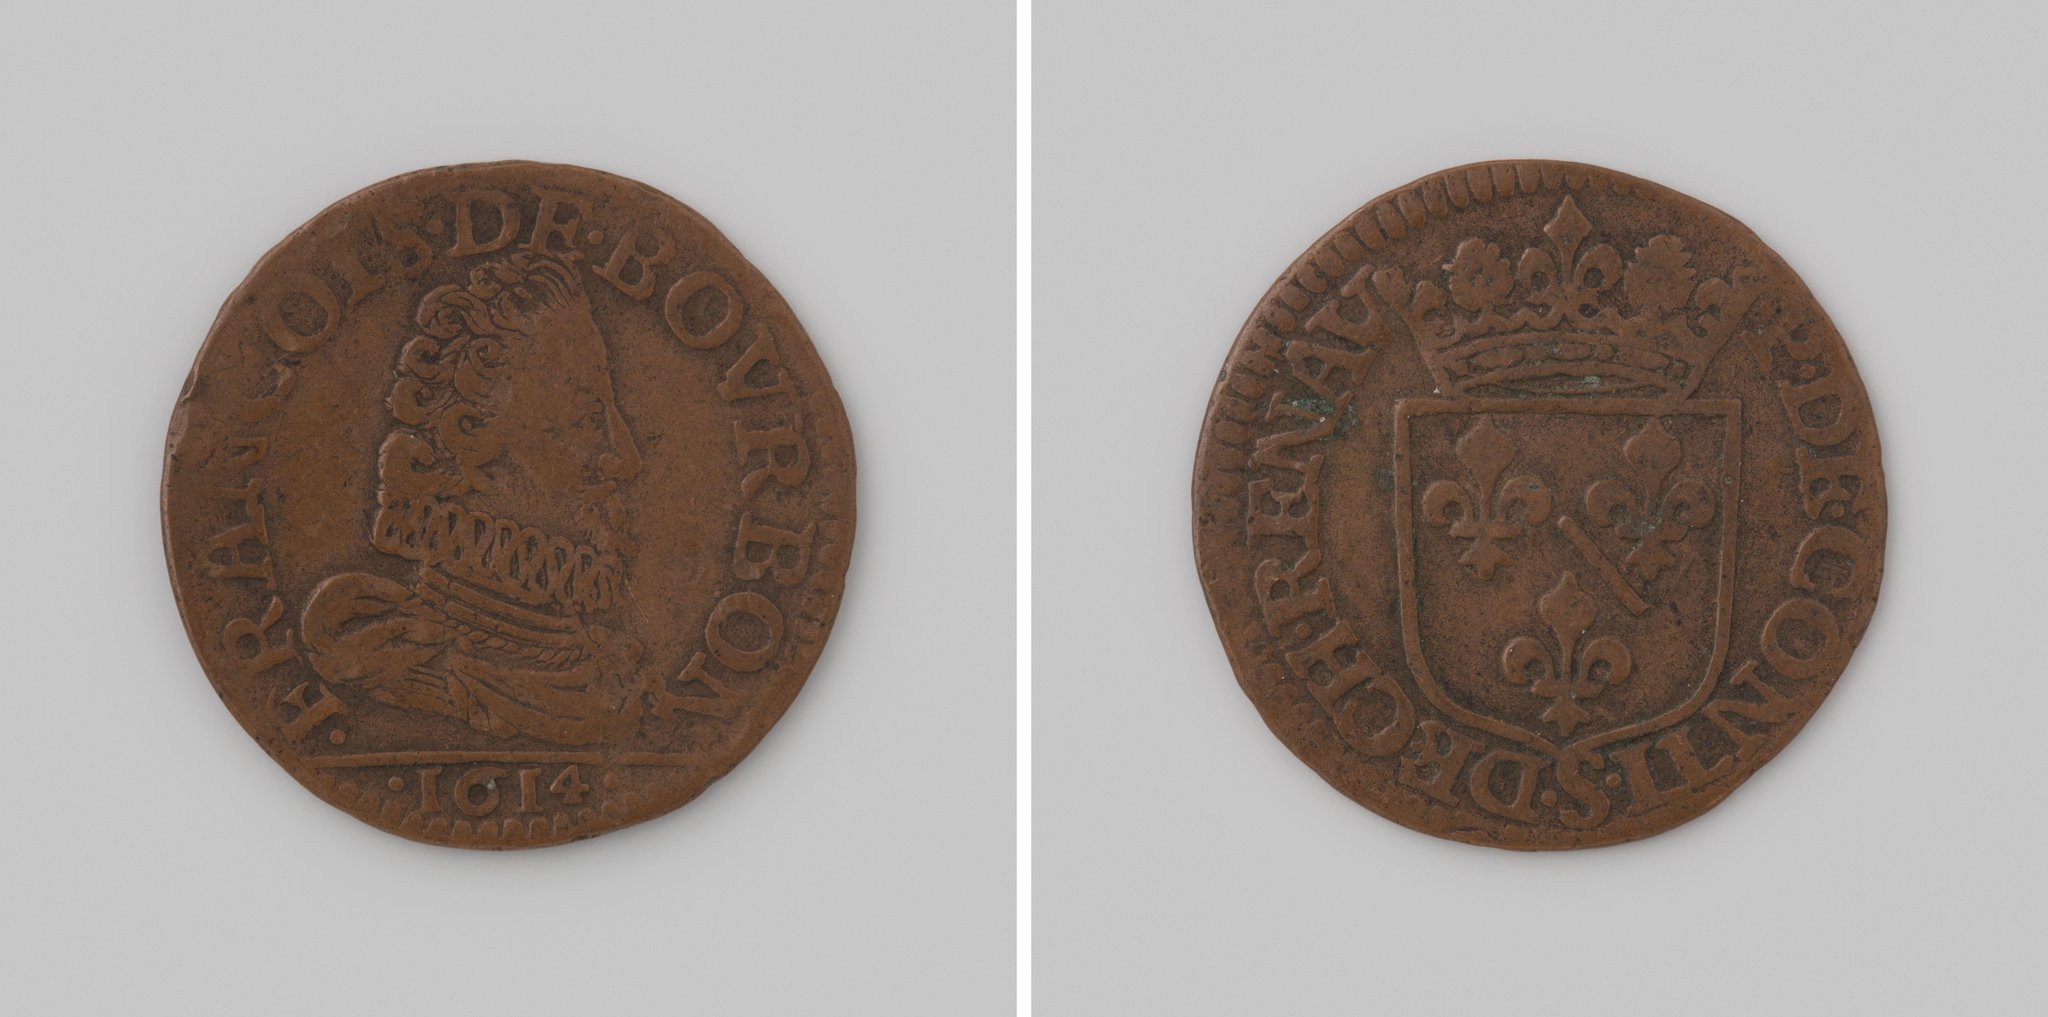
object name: coin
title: Prinsdom Chateau-Renaud, Francois de Bourbon, liard, 1613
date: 1613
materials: copper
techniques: striking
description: Koperen munt. Voorzijde: portret van de prins naar rechts. In afsnede jaartal. Keerzijde: gekroond wapenschild.